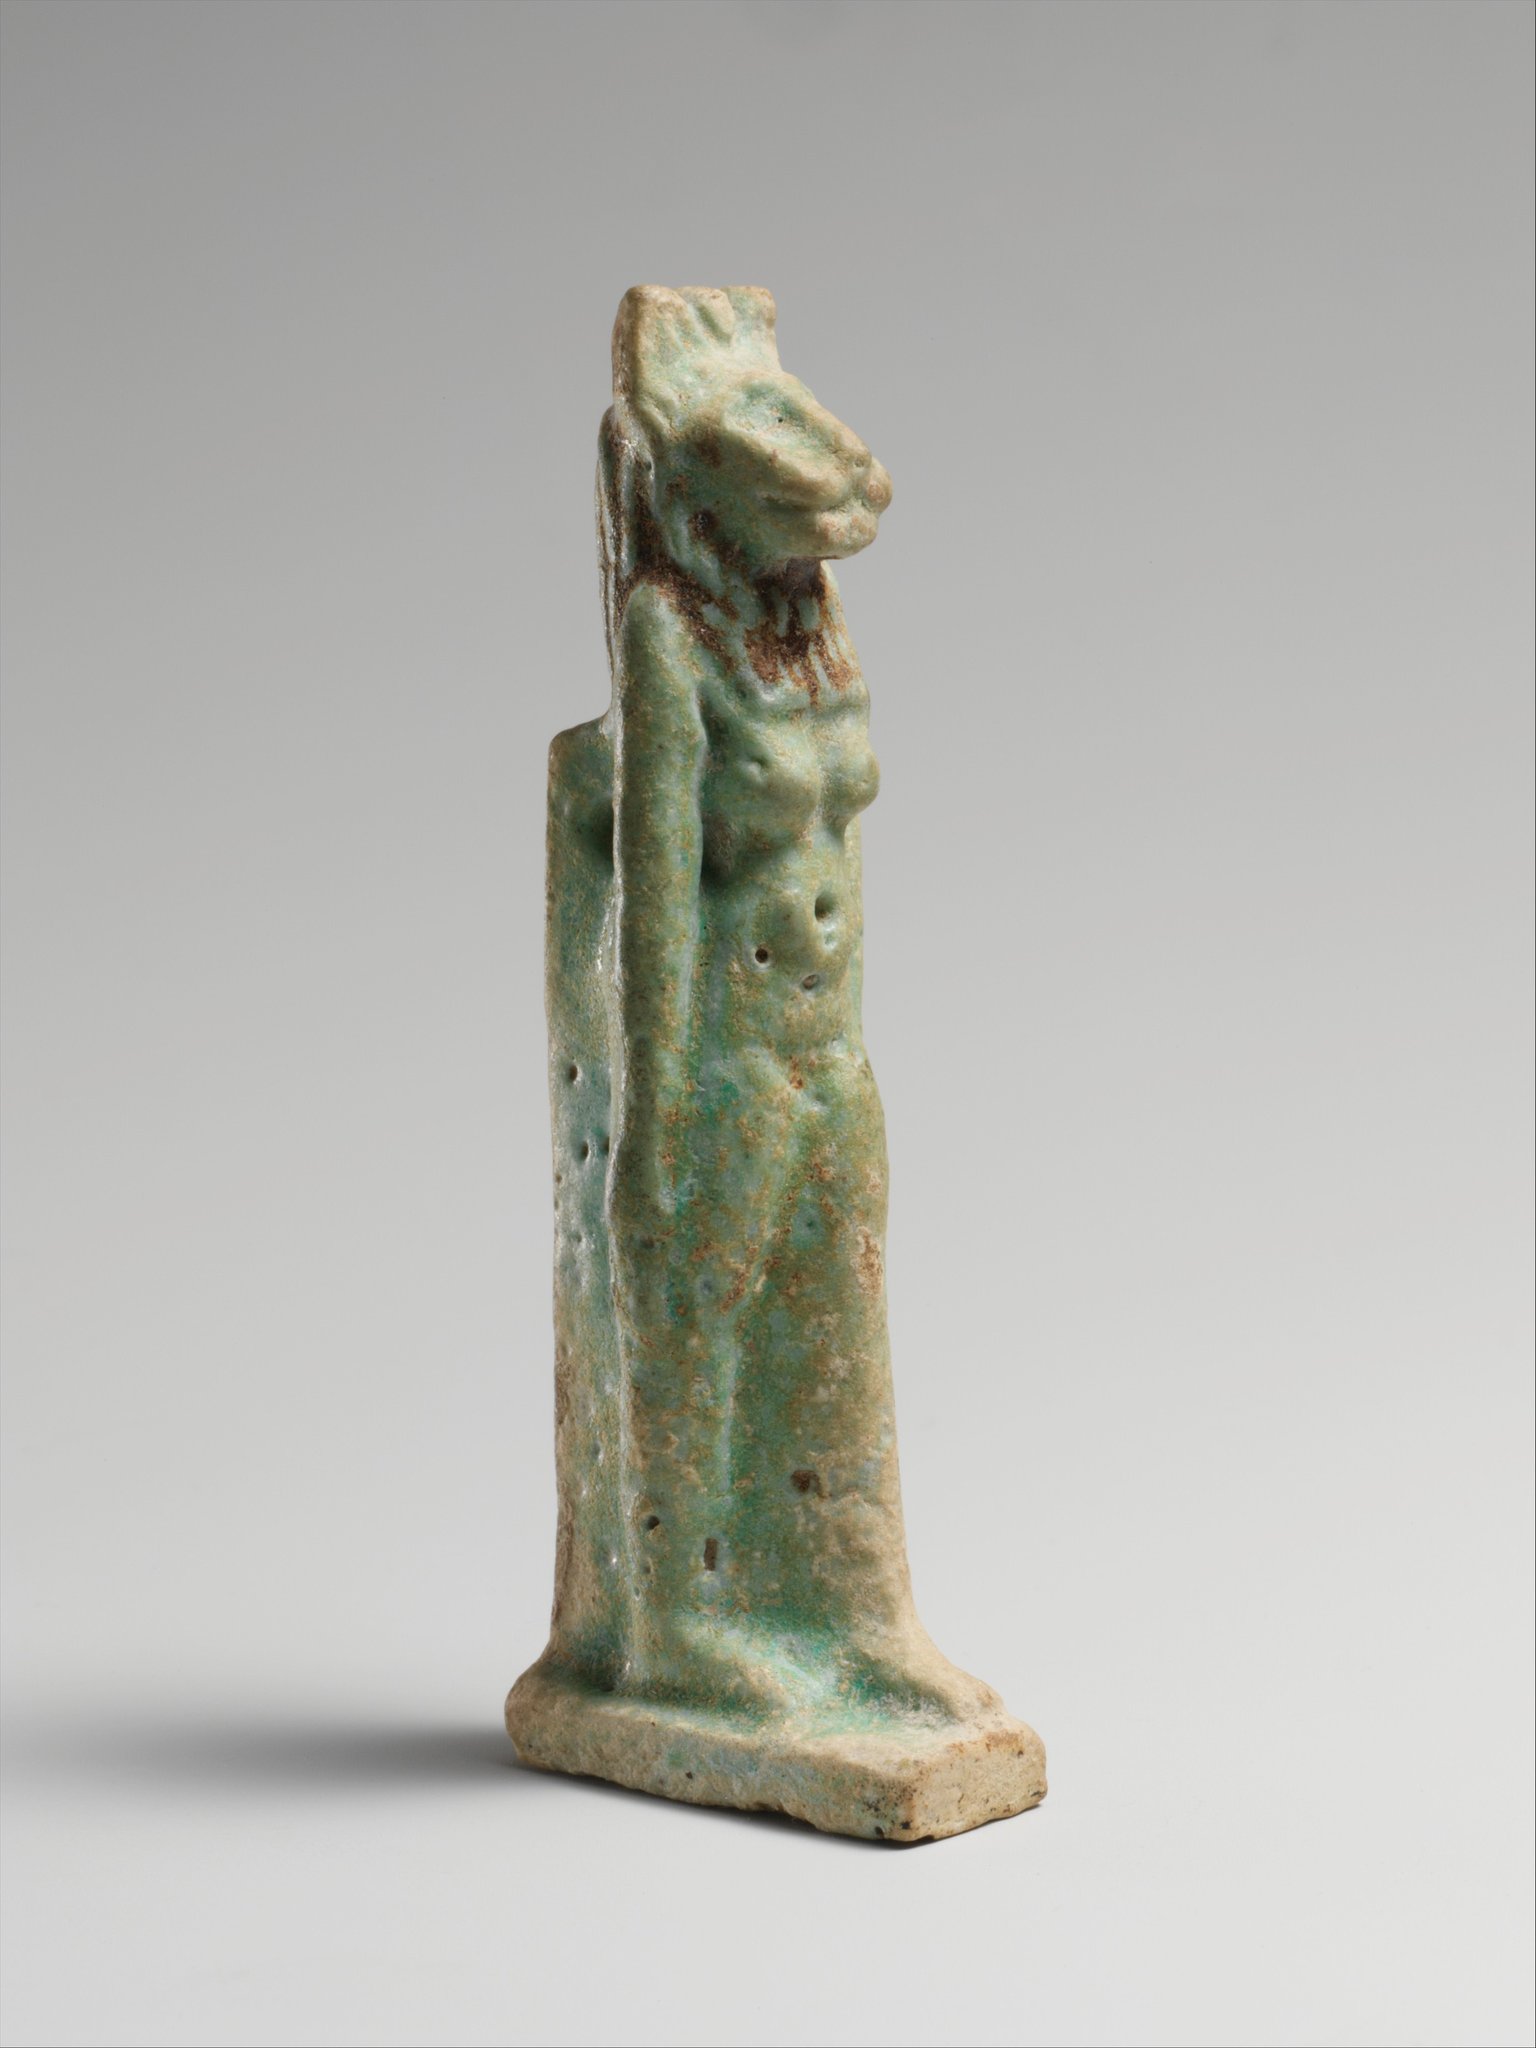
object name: amulet, bast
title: Faience amulet of a goddess with feline head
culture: egyptian, ptolemaic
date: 330-30 BCE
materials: faience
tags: sekhmet